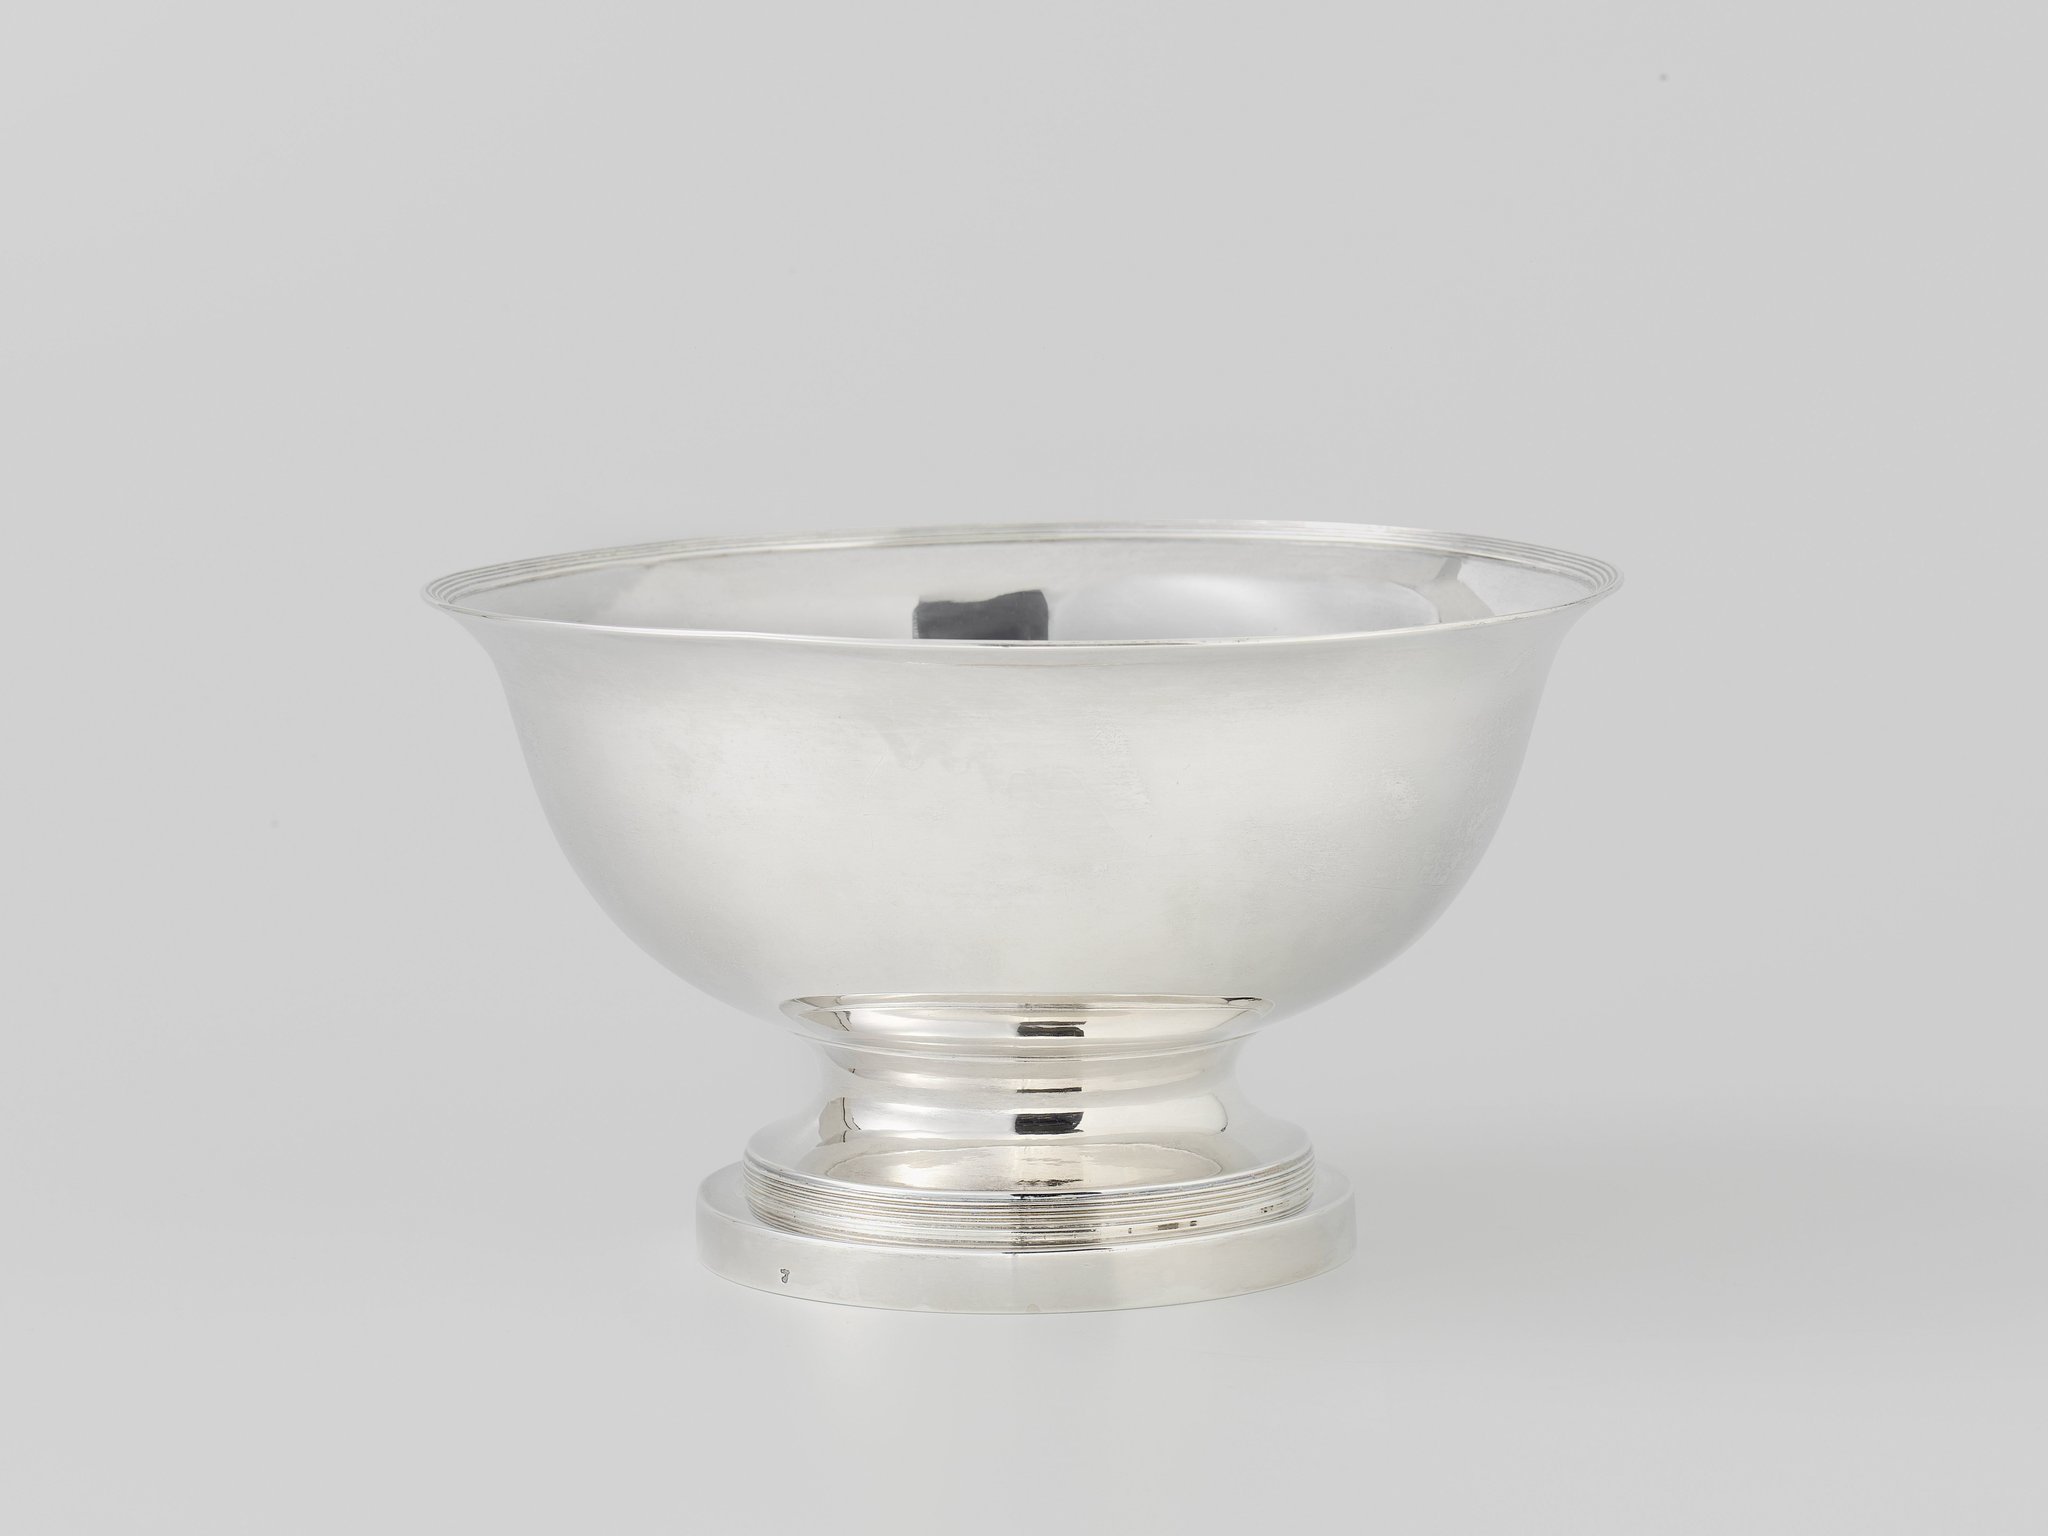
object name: slop bowl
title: Spoelkom, rond, met filetranden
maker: egidius adelaar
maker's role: silversmith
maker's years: 1768-1838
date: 1820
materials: silver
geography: amsterdam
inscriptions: maker's mark, alloy mark, assay office mark, date letter: ‘L’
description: Washbasin, silver Amsterdam, 1820, by Egidius Adelaar Given by Mr and Mrs Jaffé-Pierson, 1978